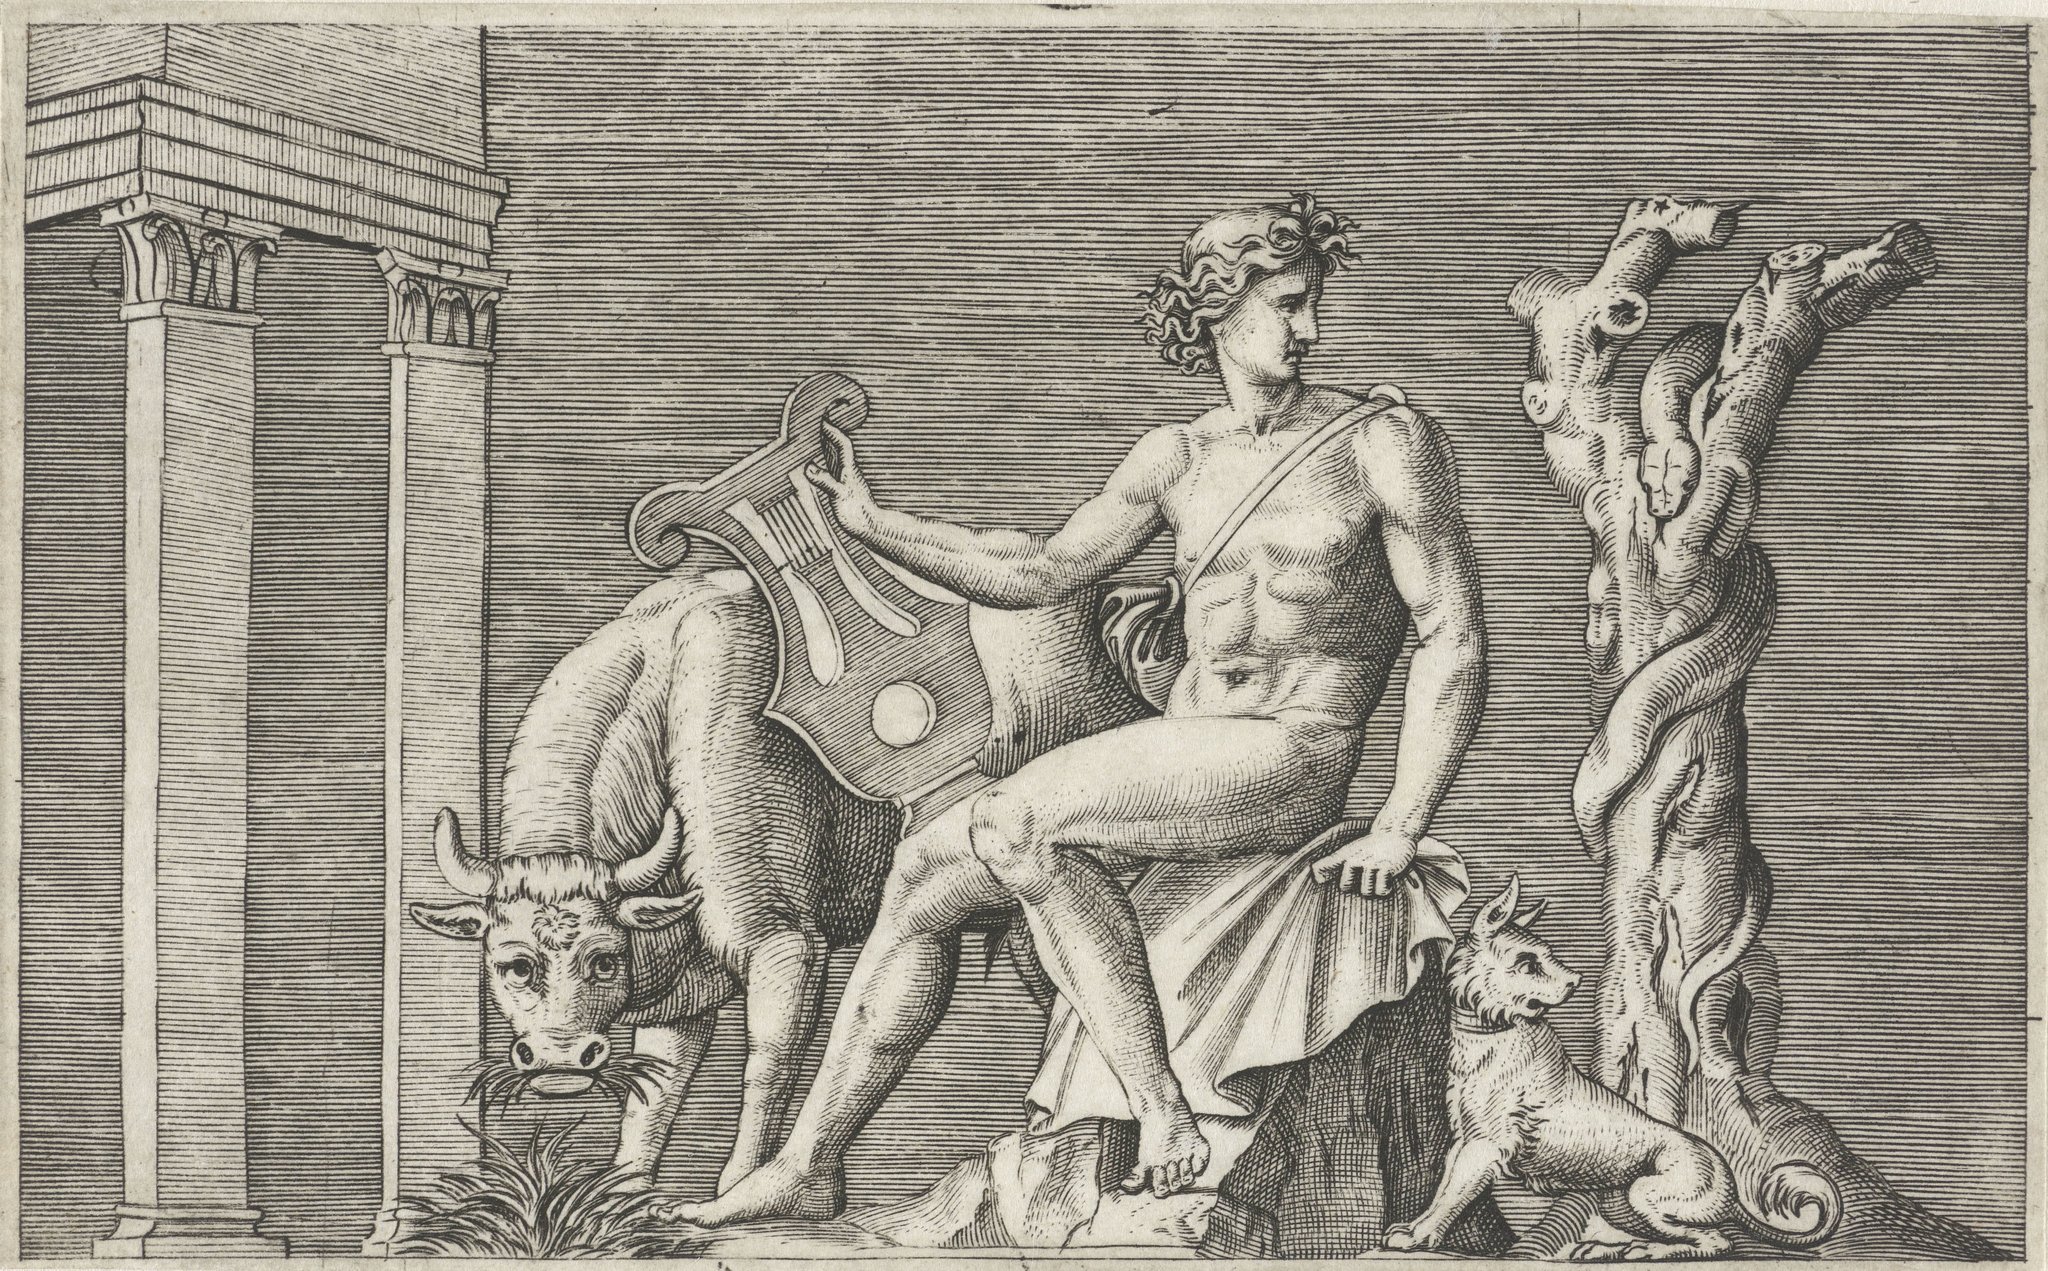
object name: print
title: Apollo bewaakt de kudde van Admetus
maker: marcantonio raimondi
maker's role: print maker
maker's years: 1470-1534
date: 1510-1527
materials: paper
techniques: engraving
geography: italy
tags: apollo tends admetus' flock as penalty for having slain the cyclopes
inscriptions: collector's mark: Lugt 12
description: Prent uit serie van acht prenten met mythologische voorstellingen naar oude bas-reliëfs. Enkele prenten uit de serie zijn toeschreven aan Marco Dente. In de collectie van het RMA bevinden zich twee verschillende staten van deze prent.